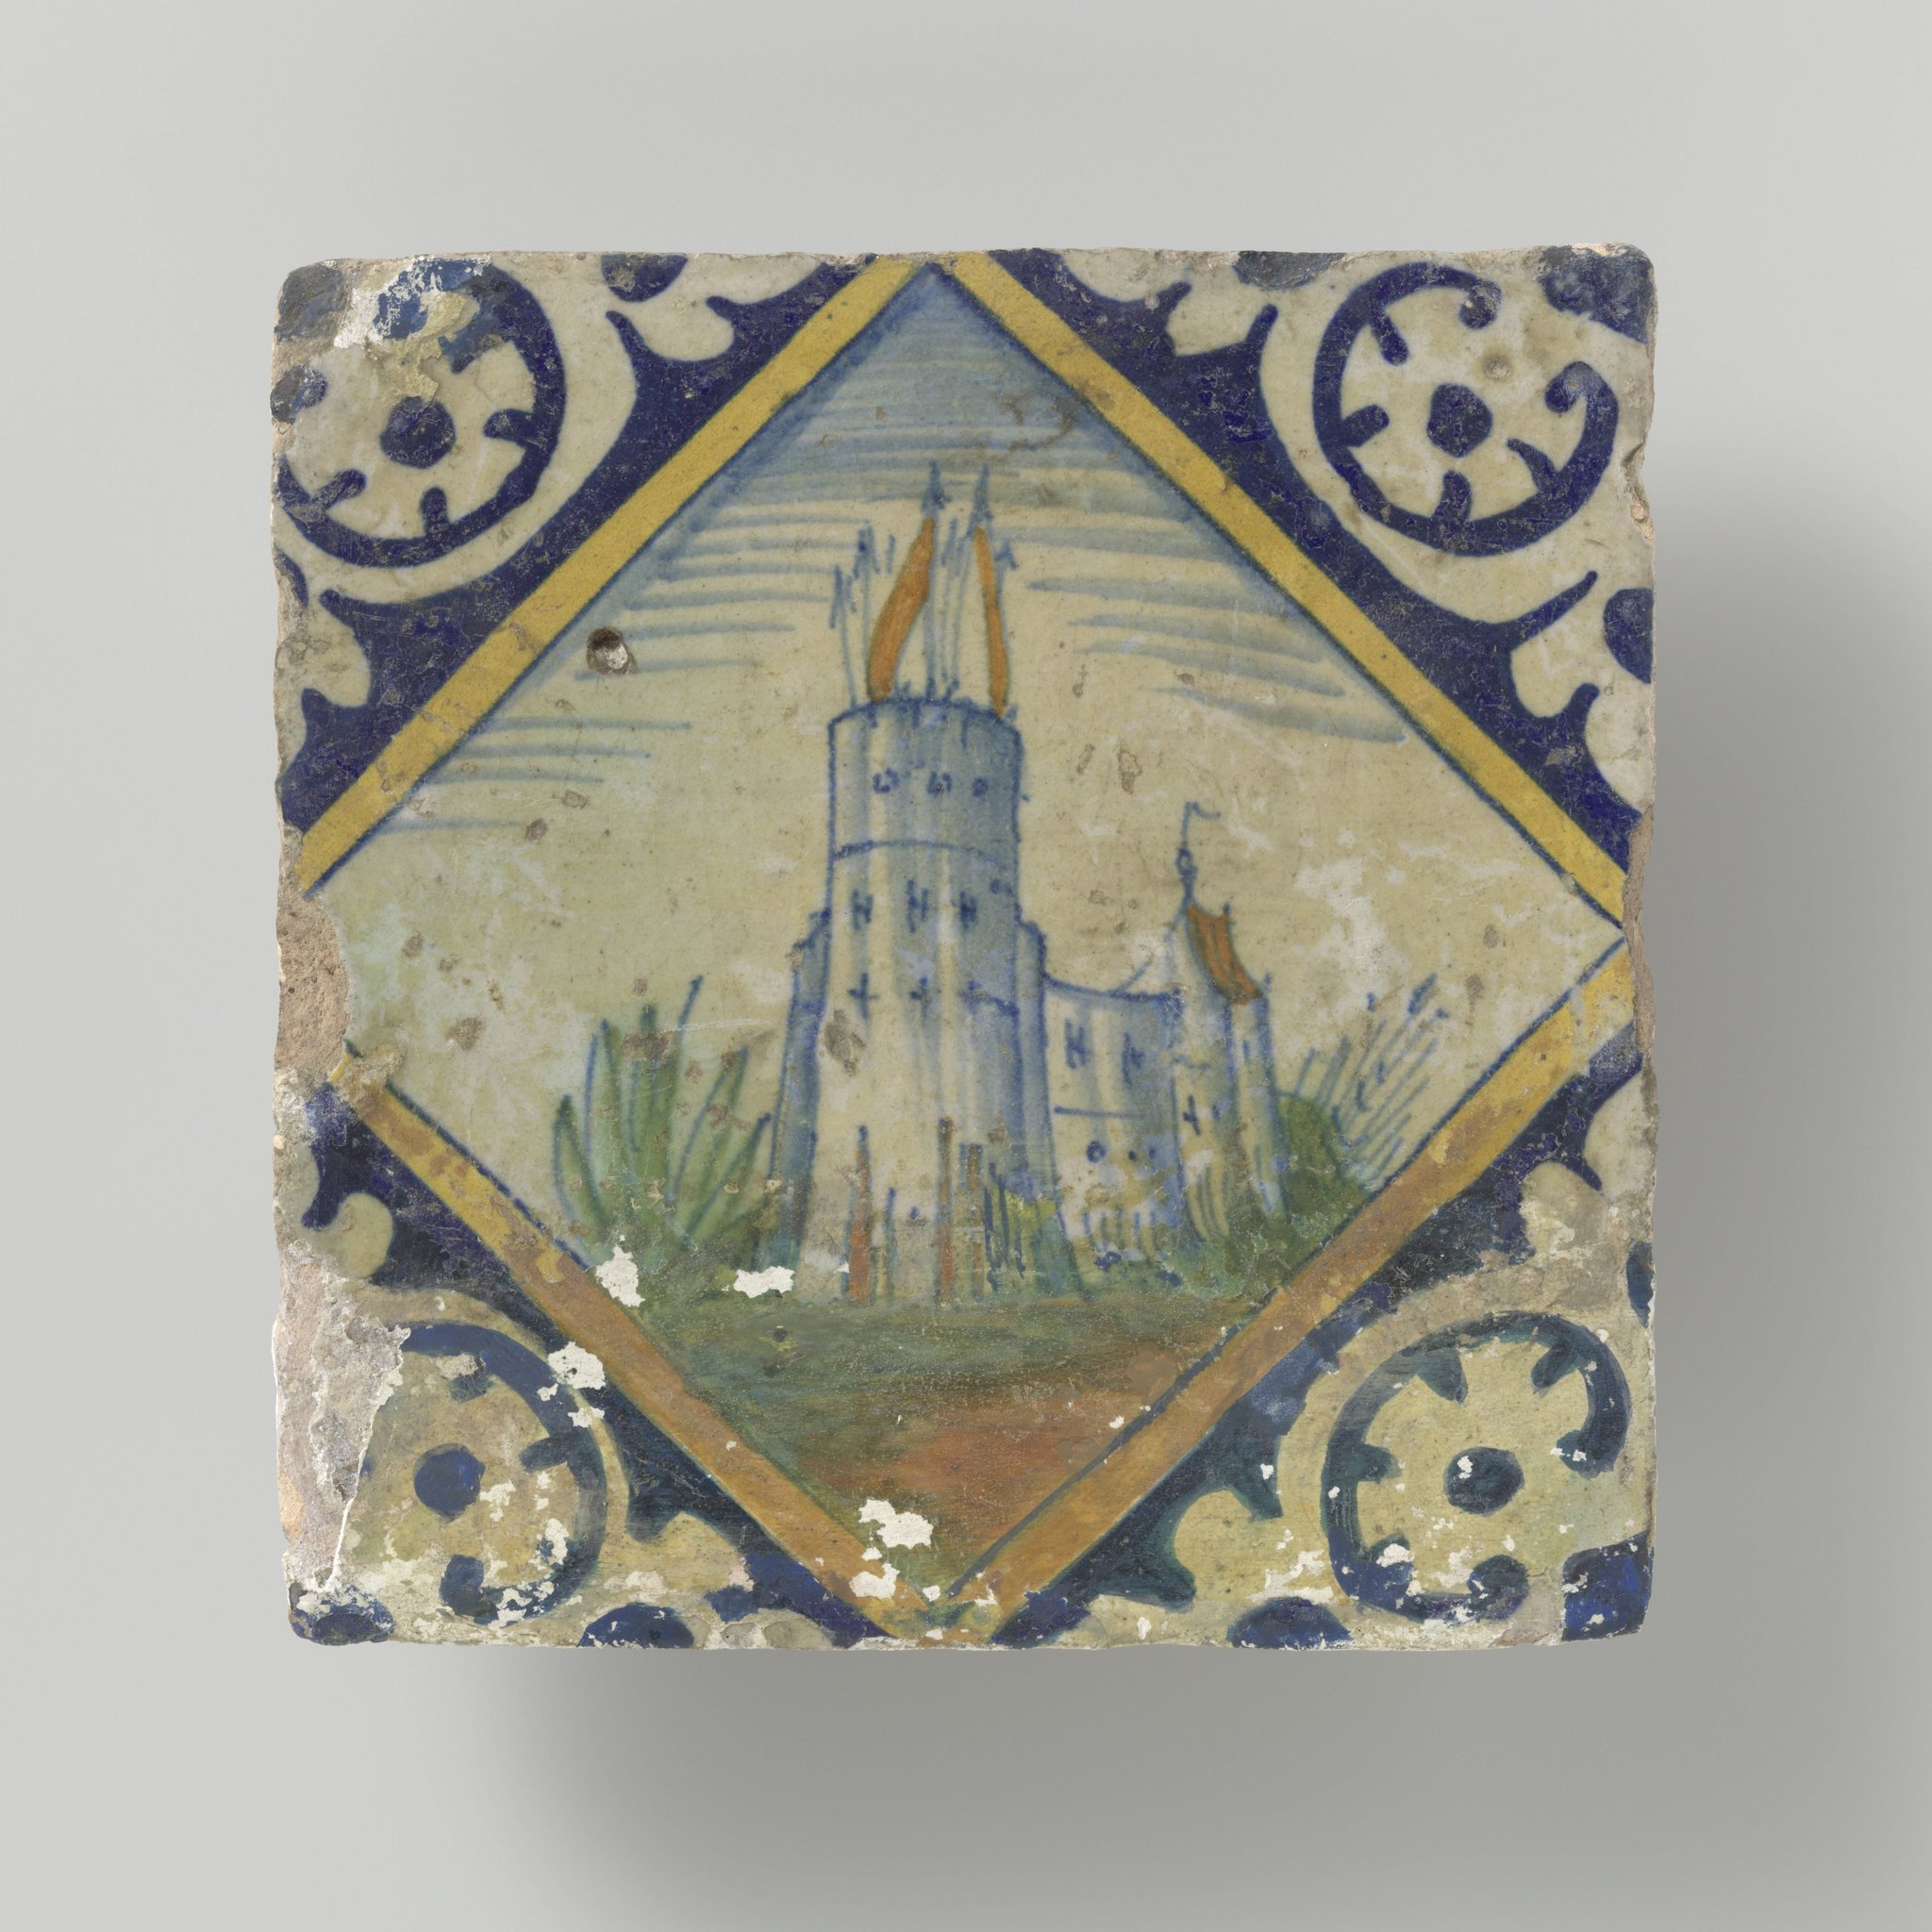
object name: tile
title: Tegel met kasteel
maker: Anonymous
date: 1580-1625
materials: earthenware, glaze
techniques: maiolica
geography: netherlands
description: Tegel met een veelkleurig (blauw, oranje, geel en groen) kasteel binnen een kwadraat met in de hoeken, ornament in vultechniek.